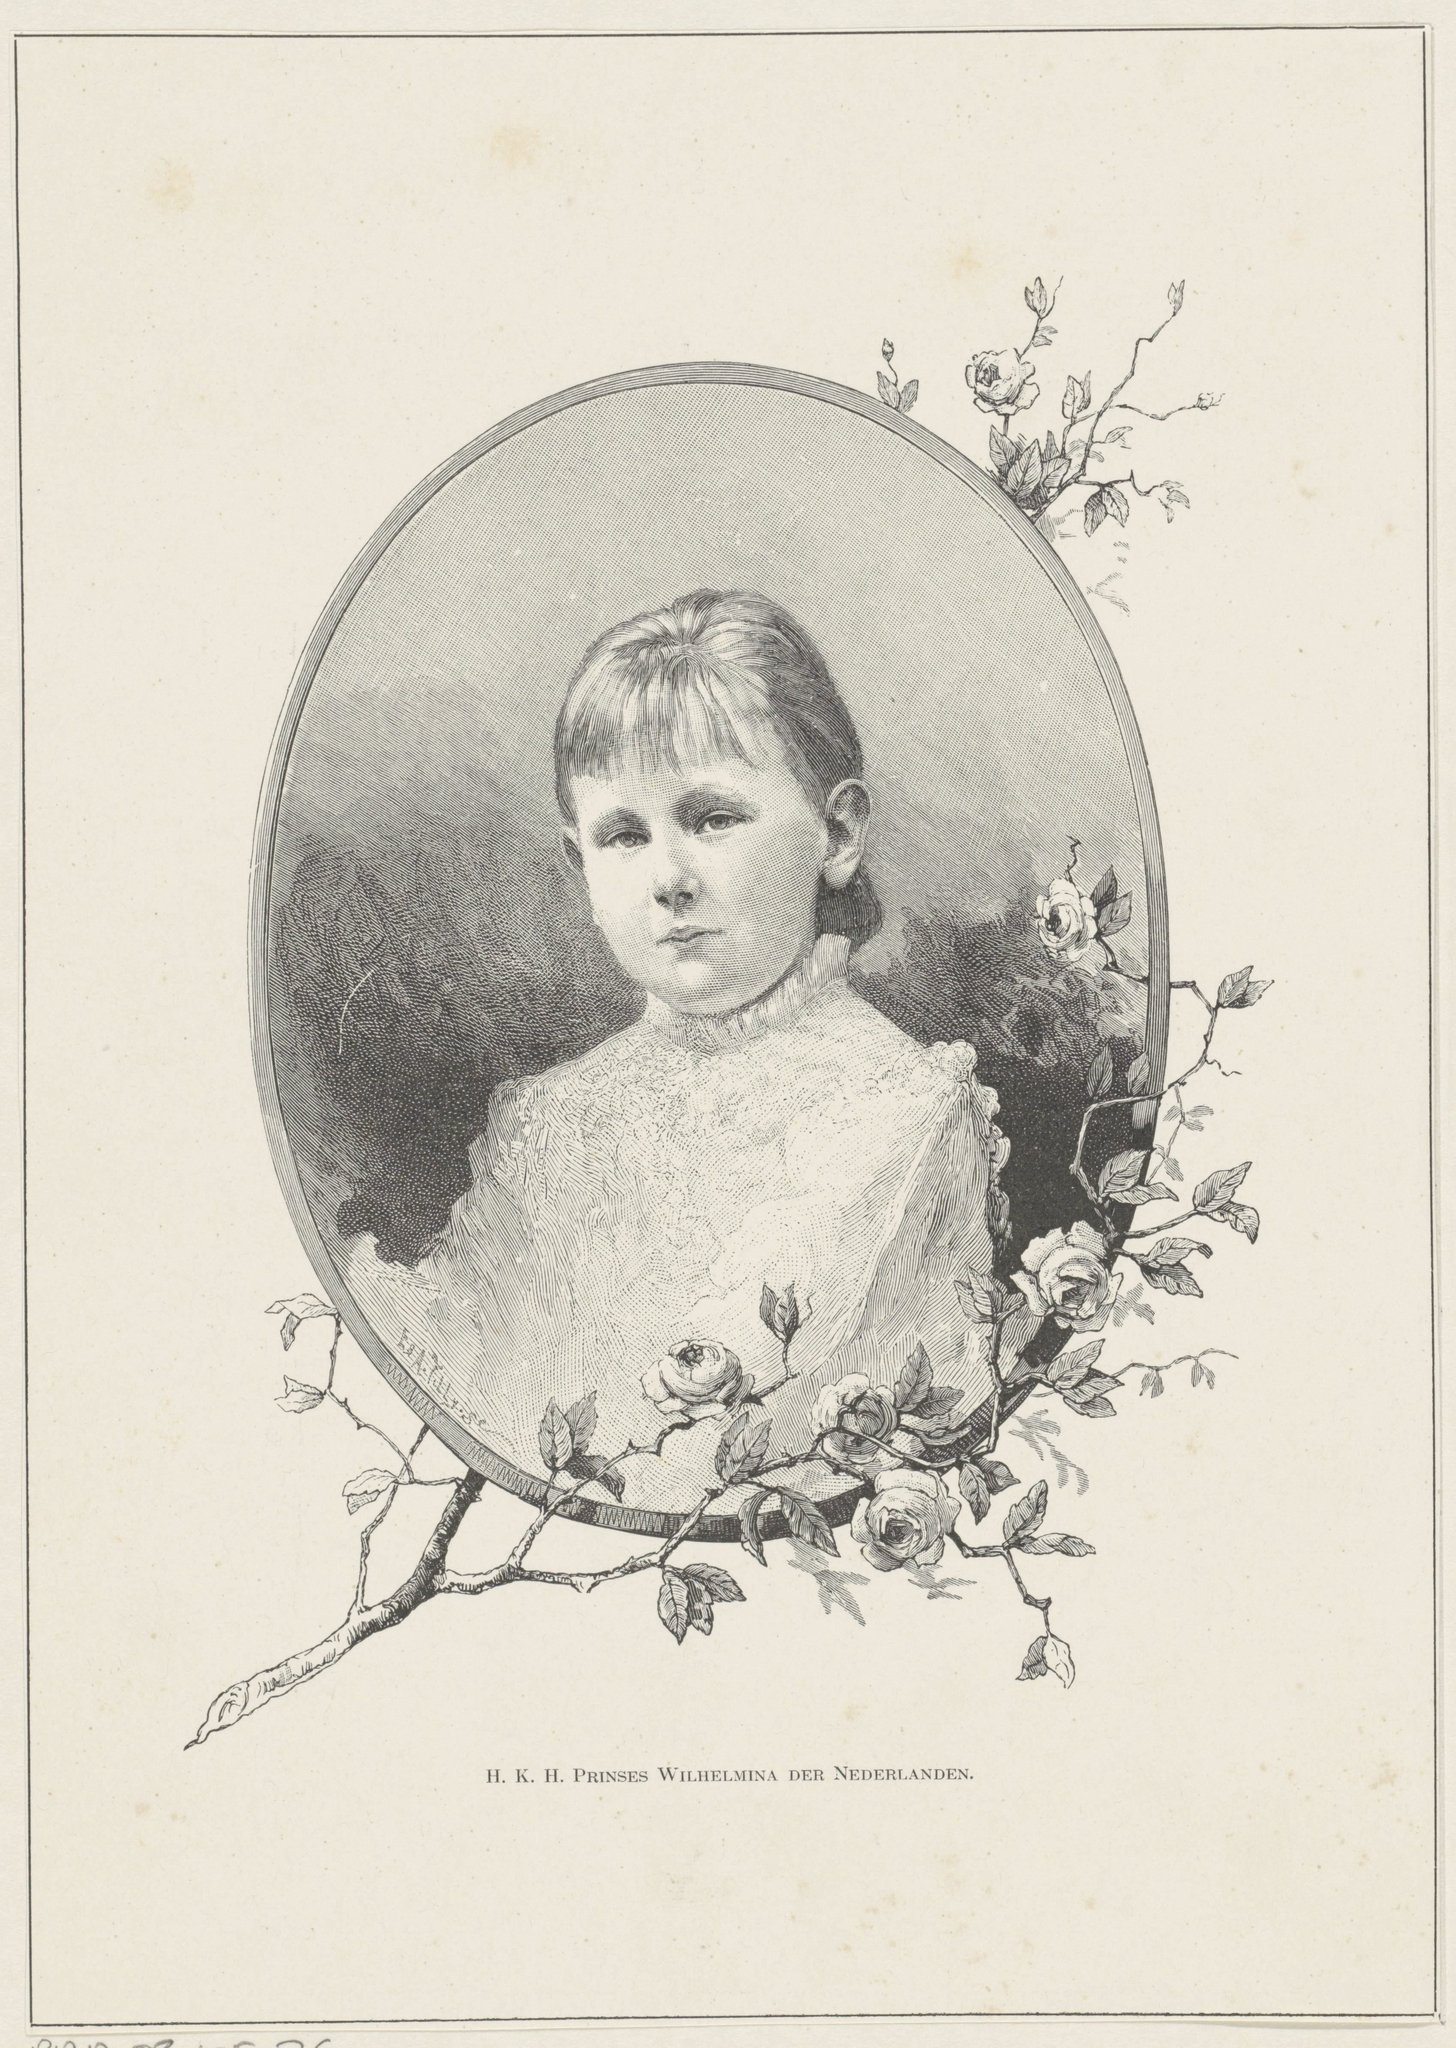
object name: print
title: Portret van Wilhelmina, koningin der Nederlanden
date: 1883-1890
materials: paper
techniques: letterpress printing, engraving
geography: amsterdam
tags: the hague, print maker, wilhelmina of the netherlands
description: De hier vermelde titel verwijst naar de hoogst verkregen titel van de geportretteerde, niet per se naar de titel die de geportretteerde op deze voorstelling draagt.